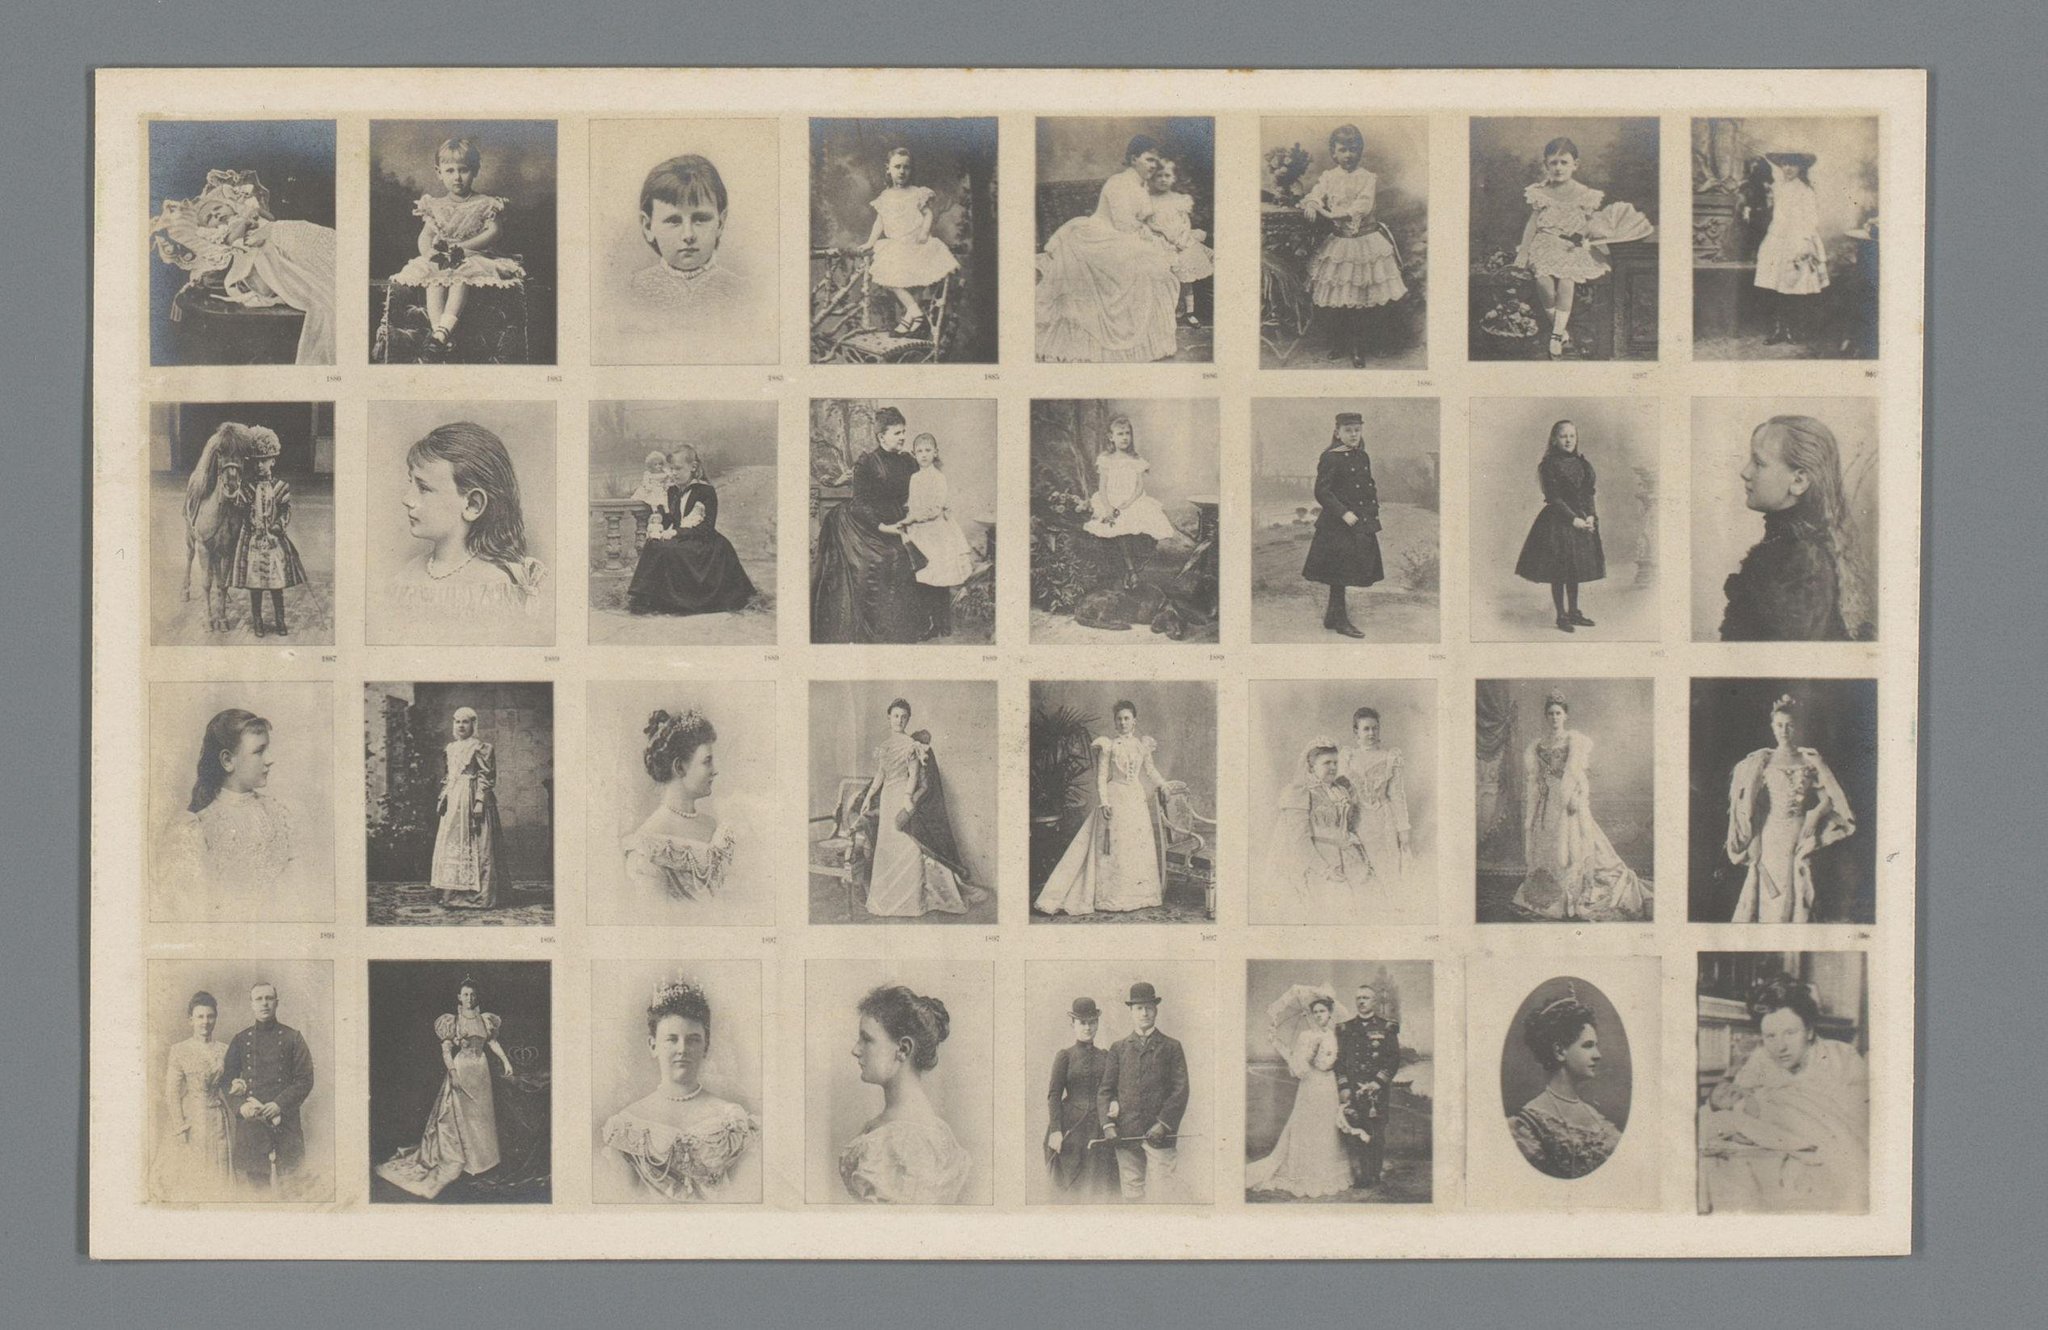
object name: ansichtkaart, prentbriefkaart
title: H. M. Koningin Wilhelmina 31 Aug. 1880 van Kind tot Moeder. 30 Apr. 1909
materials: paper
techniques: gelatin silver print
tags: the hague, print maker, wilhelmina of the netherlands, queen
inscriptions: number: ‘1276’